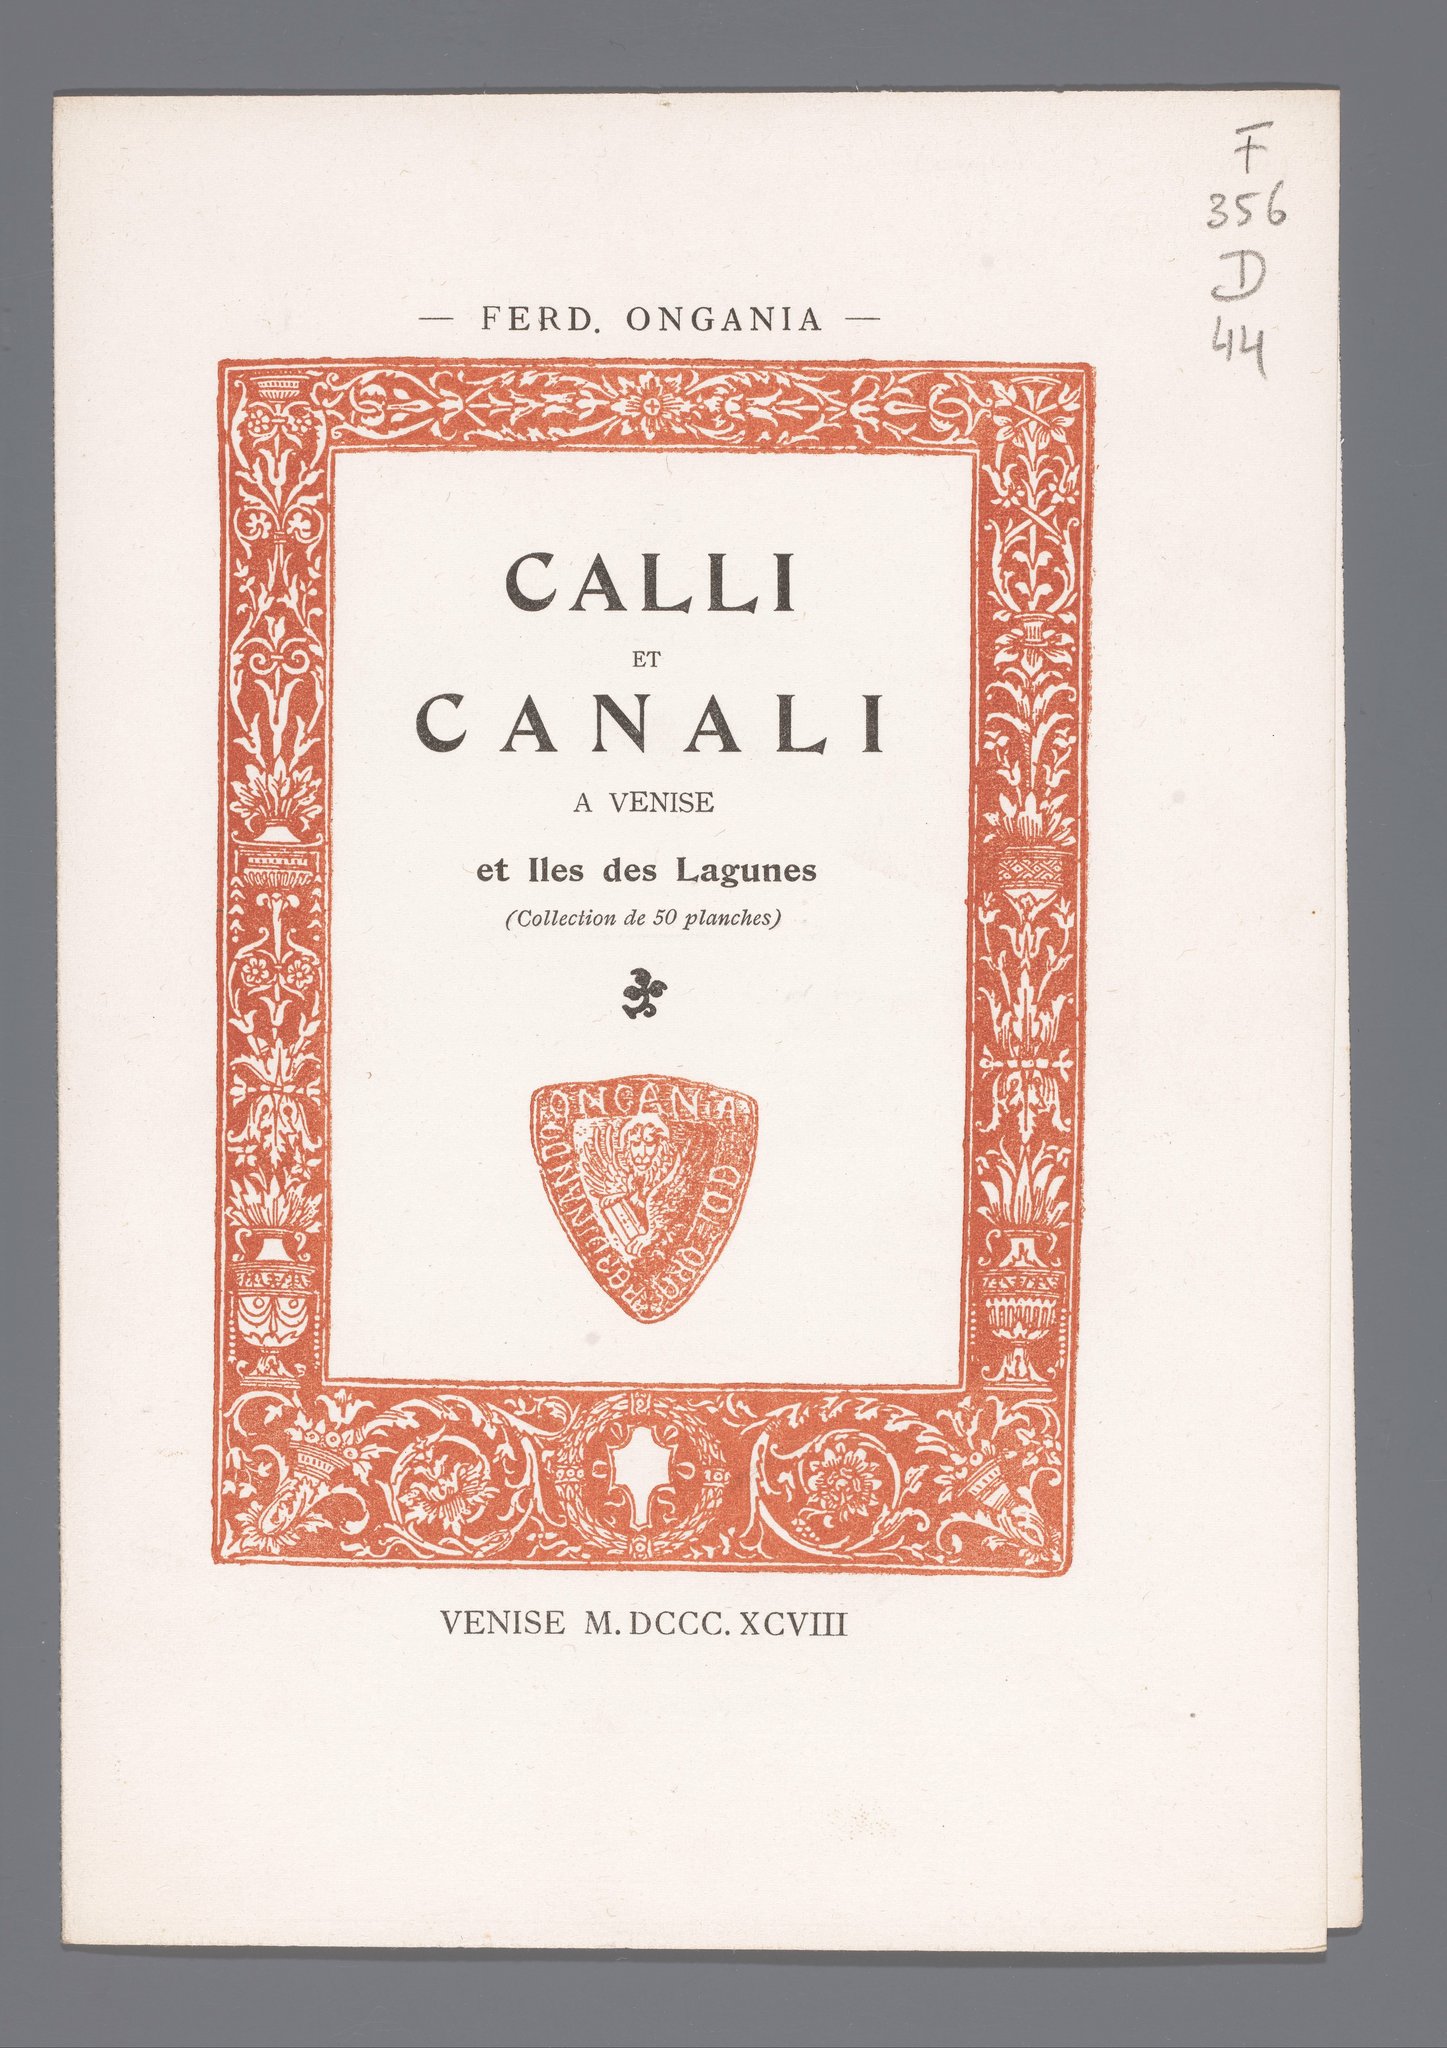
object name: book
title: Calli et canali à Venise et îles des Lagunes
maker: ferdinando ongania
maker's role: publisher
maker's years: 1842-1911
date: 1898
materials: cardboard, linen, paper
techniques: photoaquatint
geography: venice